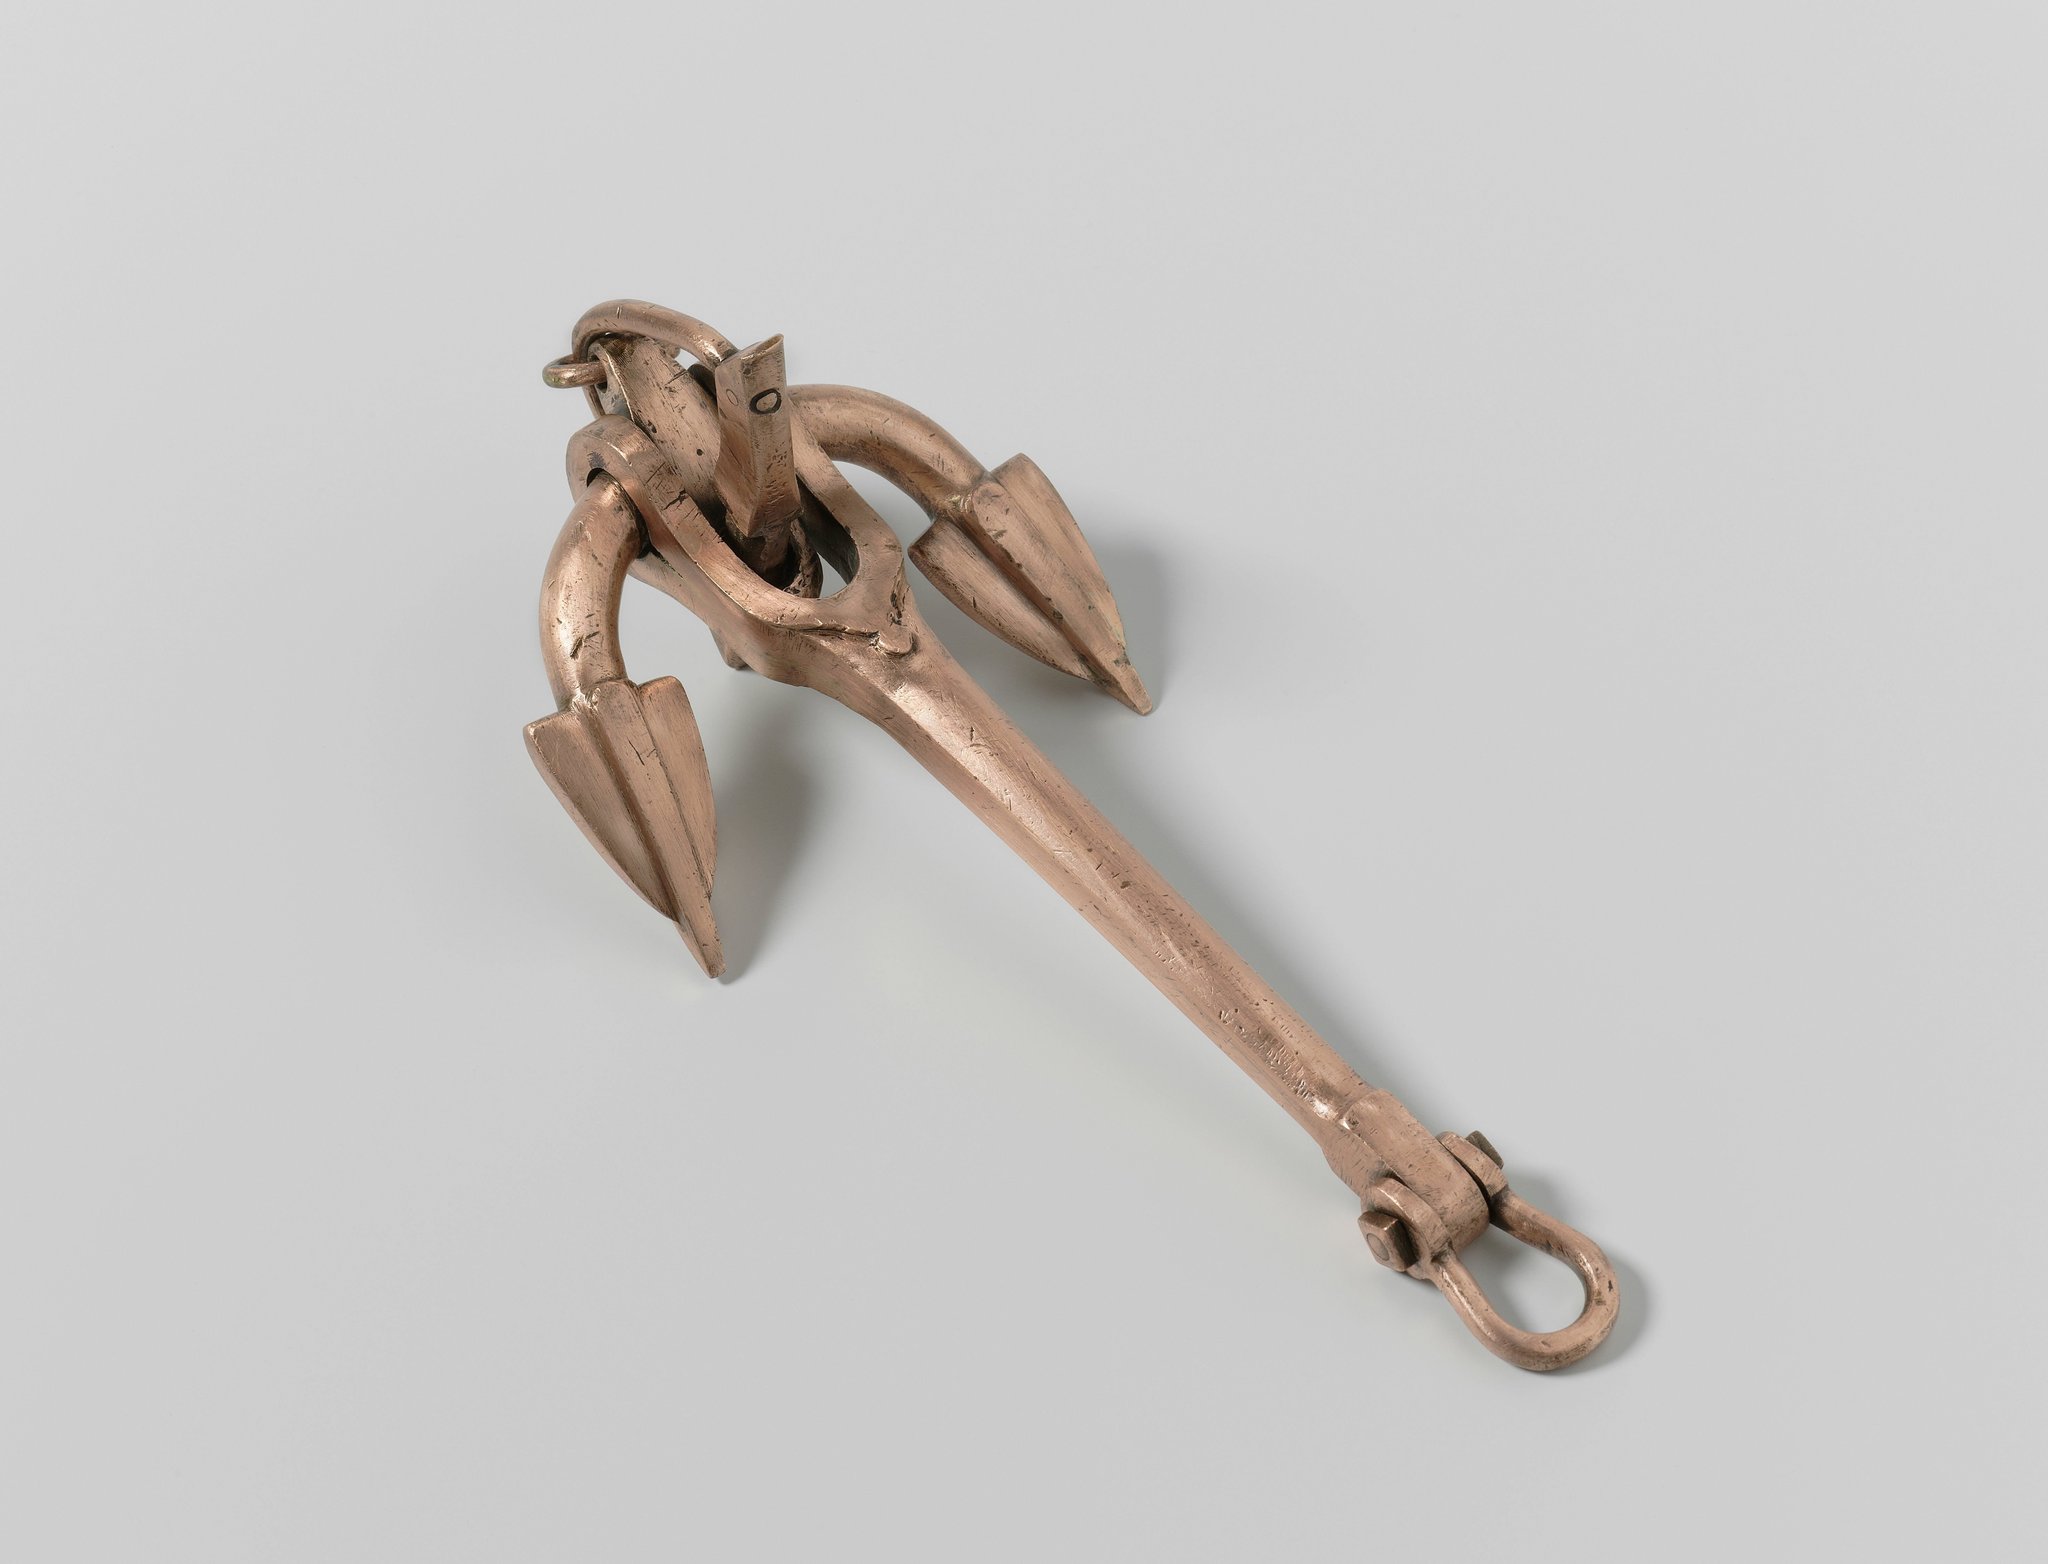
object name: demonstration model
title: Model of an Anchor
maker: william justin dealy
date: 1823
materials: copper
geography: united kingdom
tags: the hague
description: Hawkins' patent-anker werd door William Justin Dealy in Engeland in 1821 gepatenteerd en in Nederland in 1823, maar werd als R.F. Hawkins' patent-anker bij de Nederlandse Marine bekend. Het werd in 1825 op de korvet Pallas onder commando van J.C. Rijk beproefd. Het hield slecht in moddergrond.